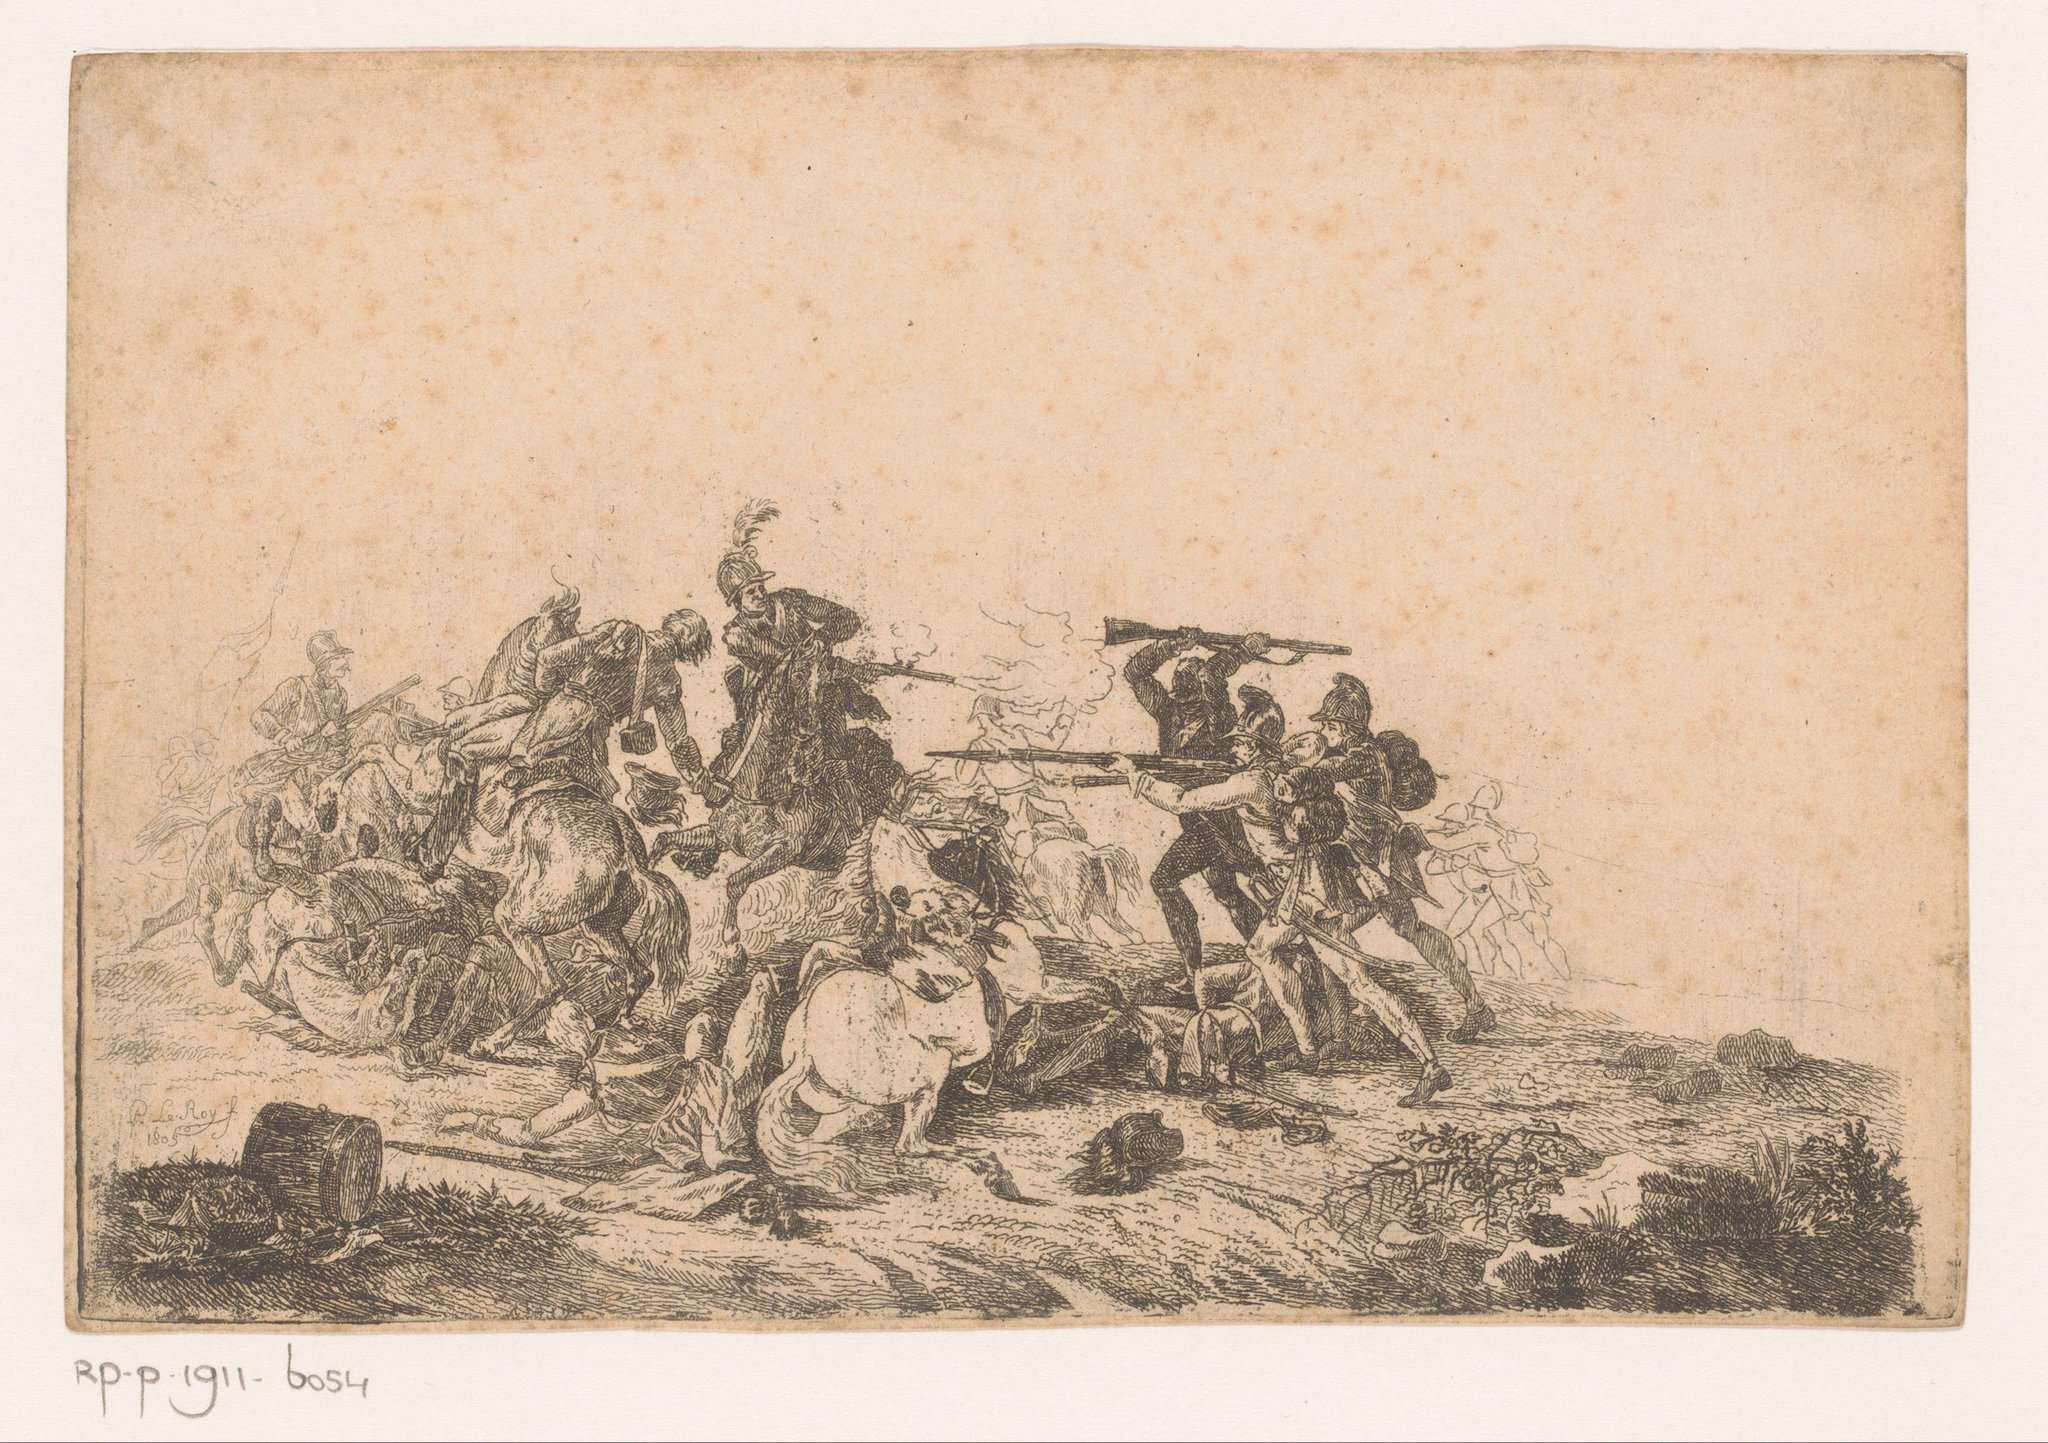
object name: print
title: Gevecht tussen cavalerie en infanterie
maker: pierre-françois le roy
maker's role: draughtsman, painter, print maker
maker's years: 1771-1862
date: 1805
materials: paper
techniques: etching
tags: private soldier (+ land forces), battle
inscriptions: collector's mark: Lugt 1485, collector's mark: Lugt 2228